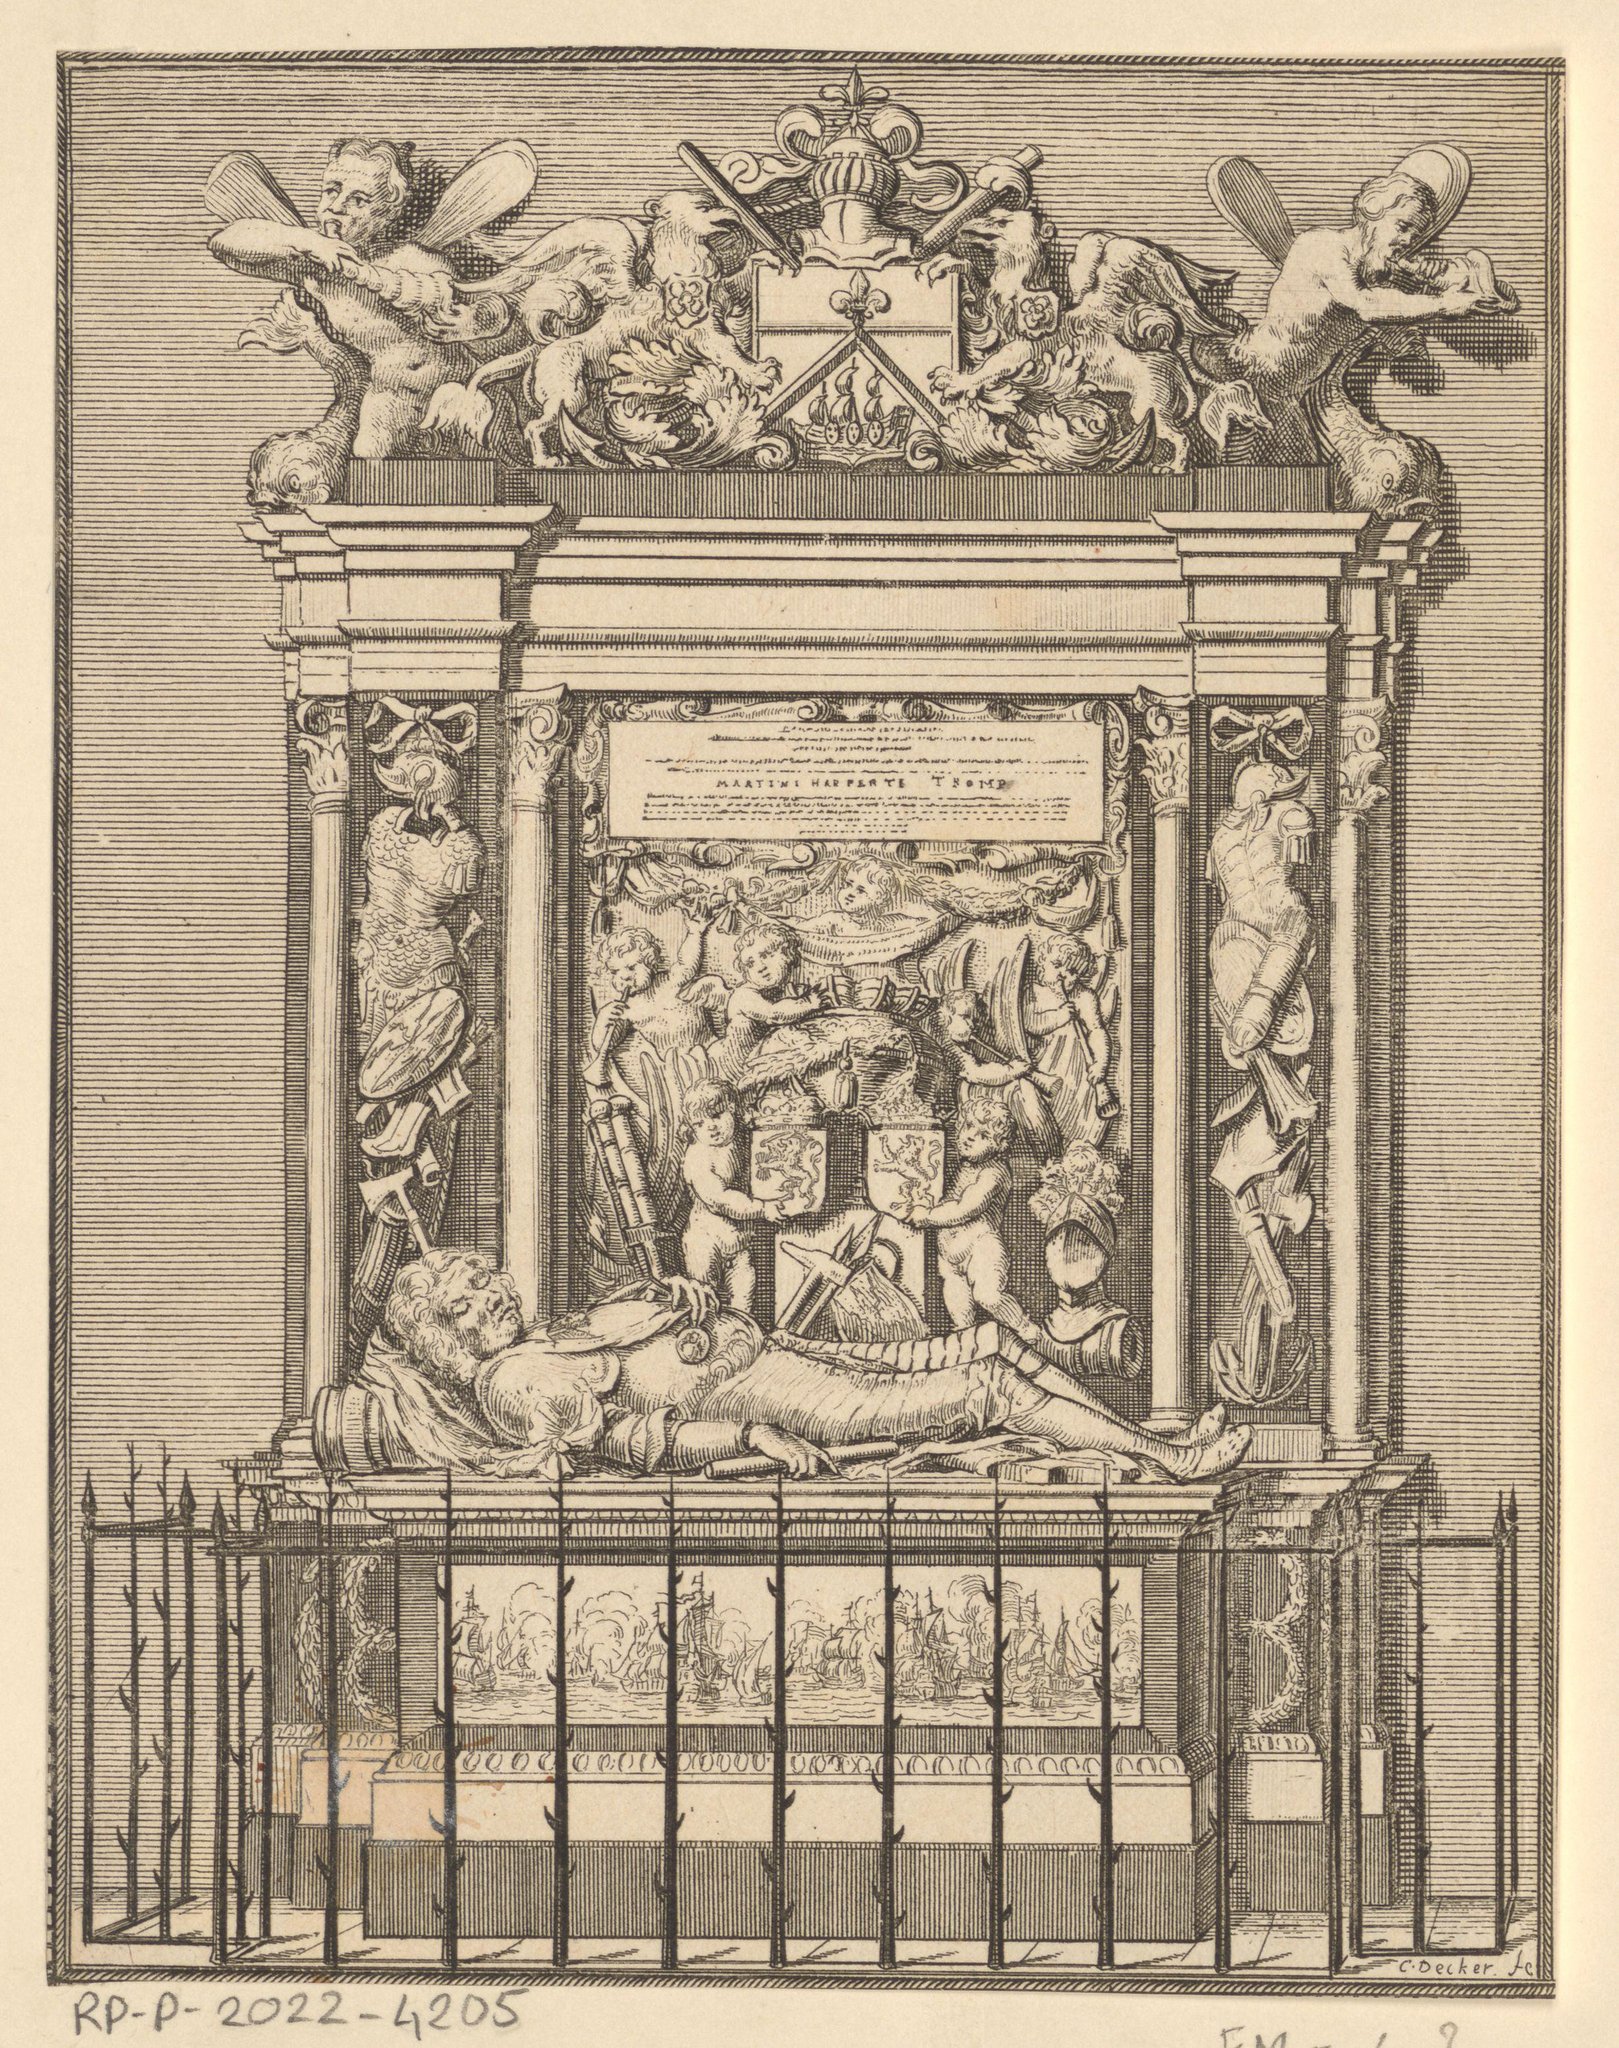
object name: print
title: Graftombe van Maarten Harpertszoon Tromp in de Oude Kerk te Delft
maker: coenraet decker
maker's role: print maker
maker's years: 1650-1685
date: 1660-1685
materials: paper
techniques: etching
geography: amsterdam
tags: brielle, maarten harpertszoon tromp, grave-building, monumental tomb